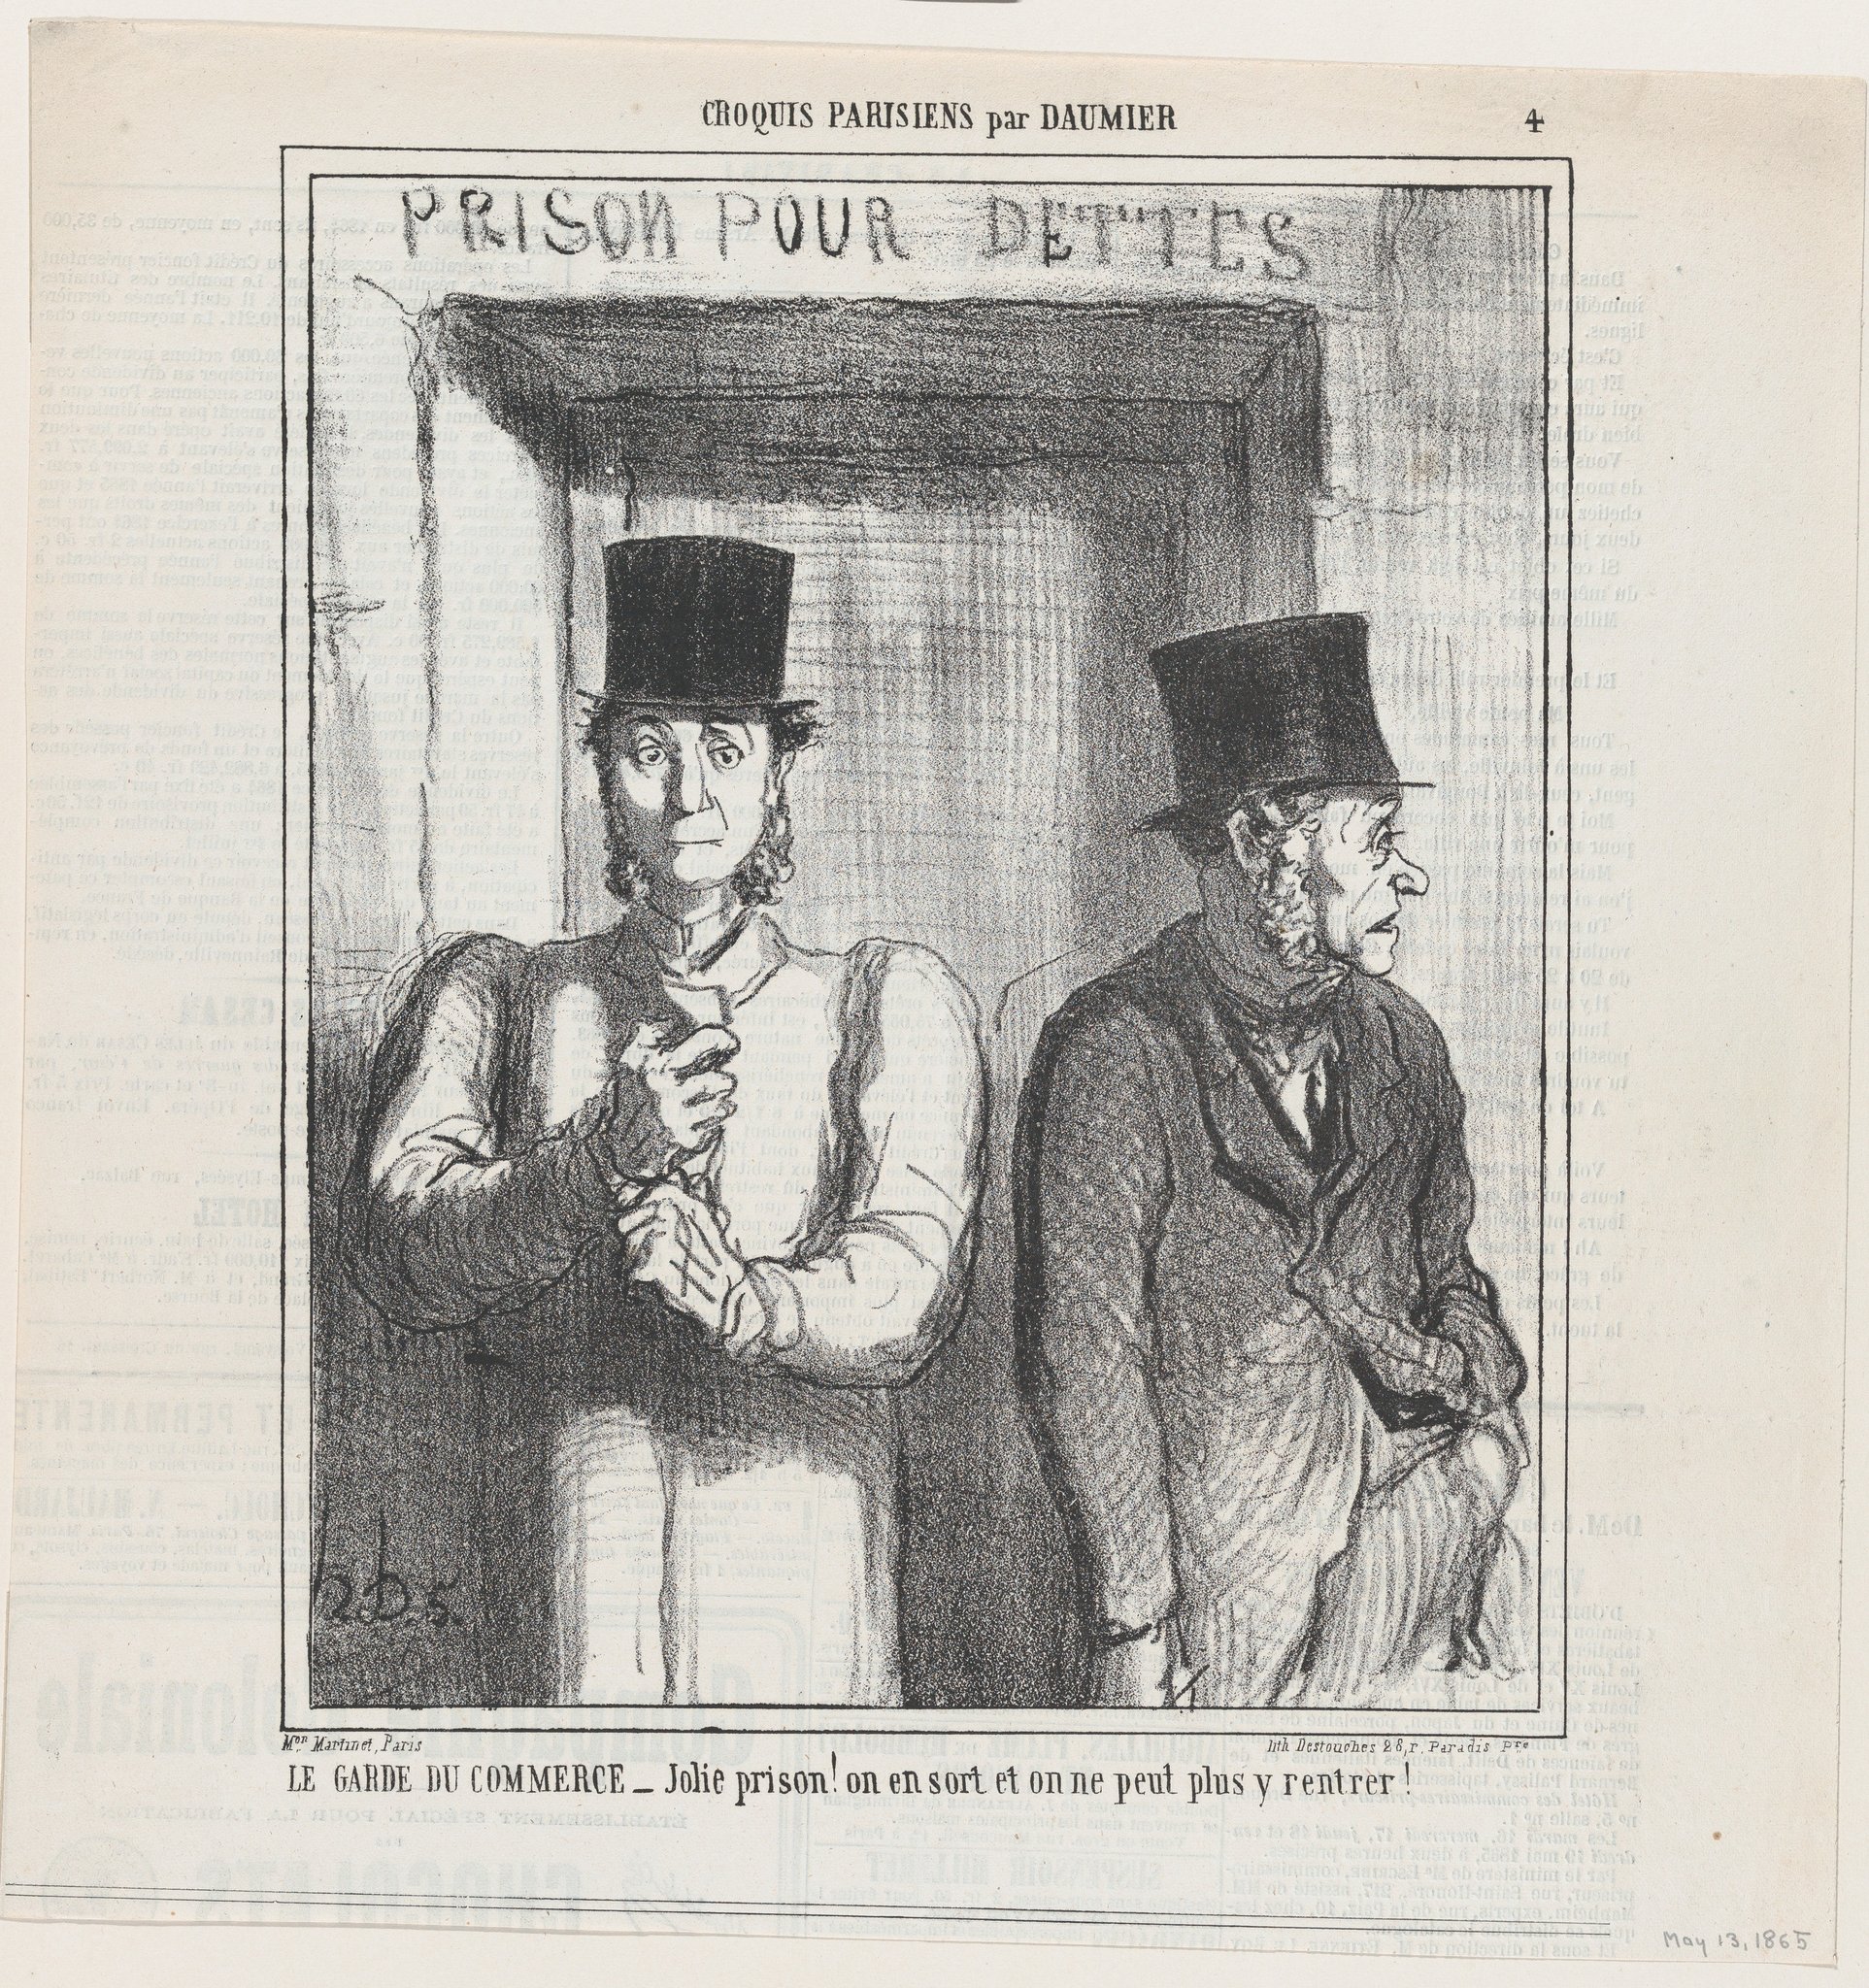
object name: print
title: Bailiff at the commercial court, from 'Parisian Sketches,' published in Le Charivari, May 13, 1865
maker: honoré daumier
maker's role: artist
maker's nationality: french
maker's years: 1808-1879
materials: paper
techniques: lithograph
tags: satire,men